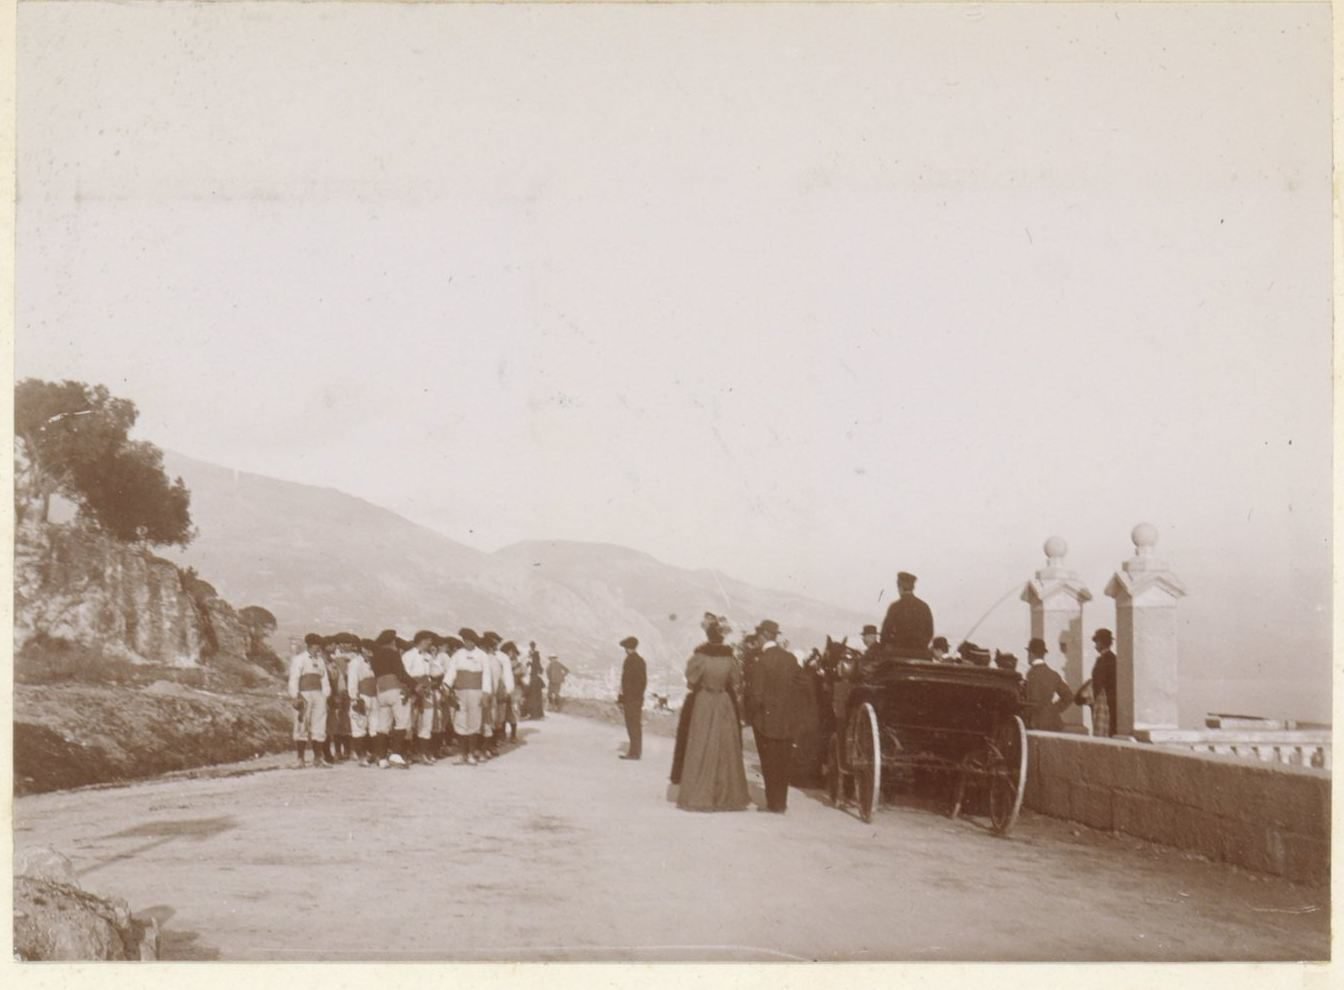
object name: photograph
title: Weg met groep mannen in kostuums en een gezelschap bij een rijtuig, vermoedelijk aan de kust van Zuid-Frankrijk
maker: Anonymous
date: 1900-1910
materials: paper, photographic support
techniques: daylight paper print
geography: southern france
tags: animal traction, animal-drawn vehicle (carriage etc.), folk costume, regional costume (+ men's clothes), public road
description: Onderdeel van Fotoalbum van een Franse amateurfotograaf met opnames van een familie, distilleerderij Delizy & Doistau Fils, het leger en bezienswaardigheden in Frankrijk.